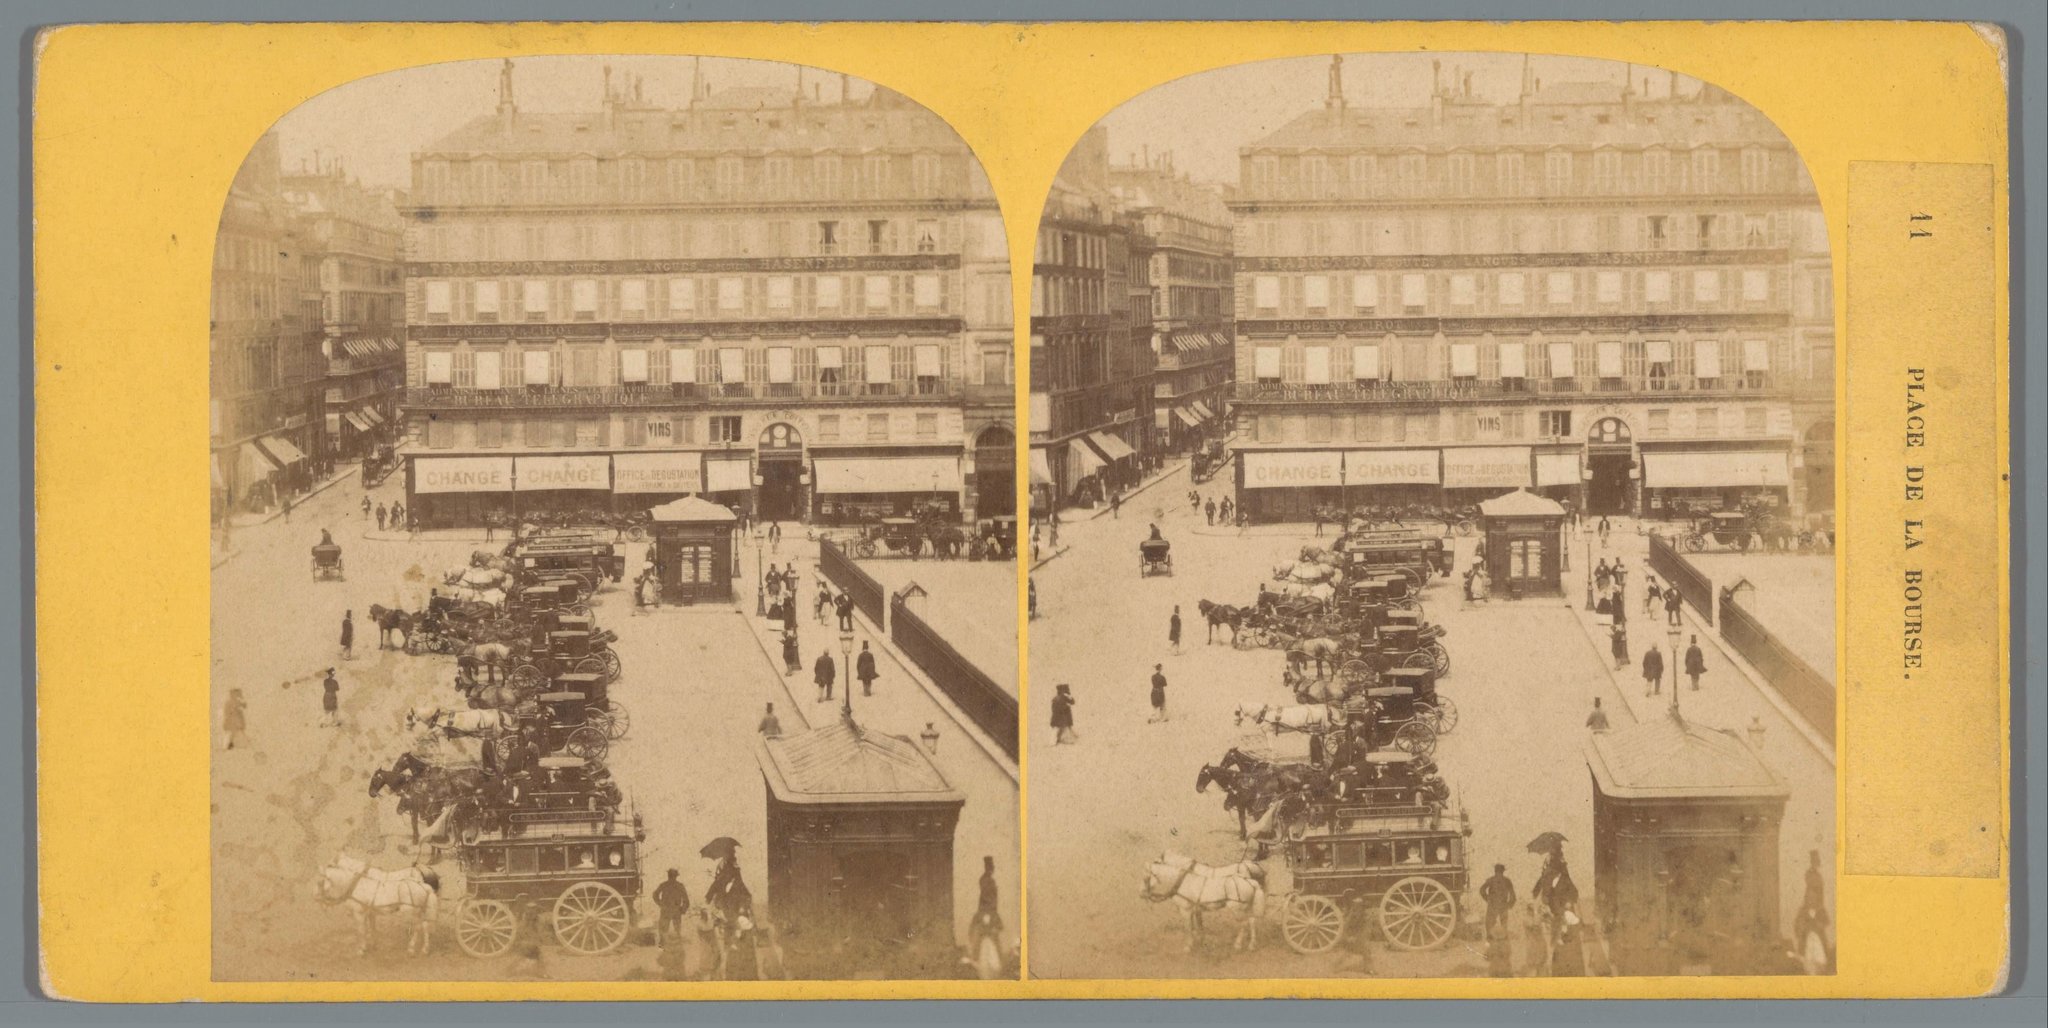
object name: stereograph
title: Gezicht op Place de la Bourse in Parijs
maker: Anonymous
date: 1850-1880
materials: cardboard, photographic support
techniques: albumen print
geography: paris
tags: square, place, circus, etc., animal traction, animal-drawn vehicle (carriage etc.)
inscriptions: number: ‘11’